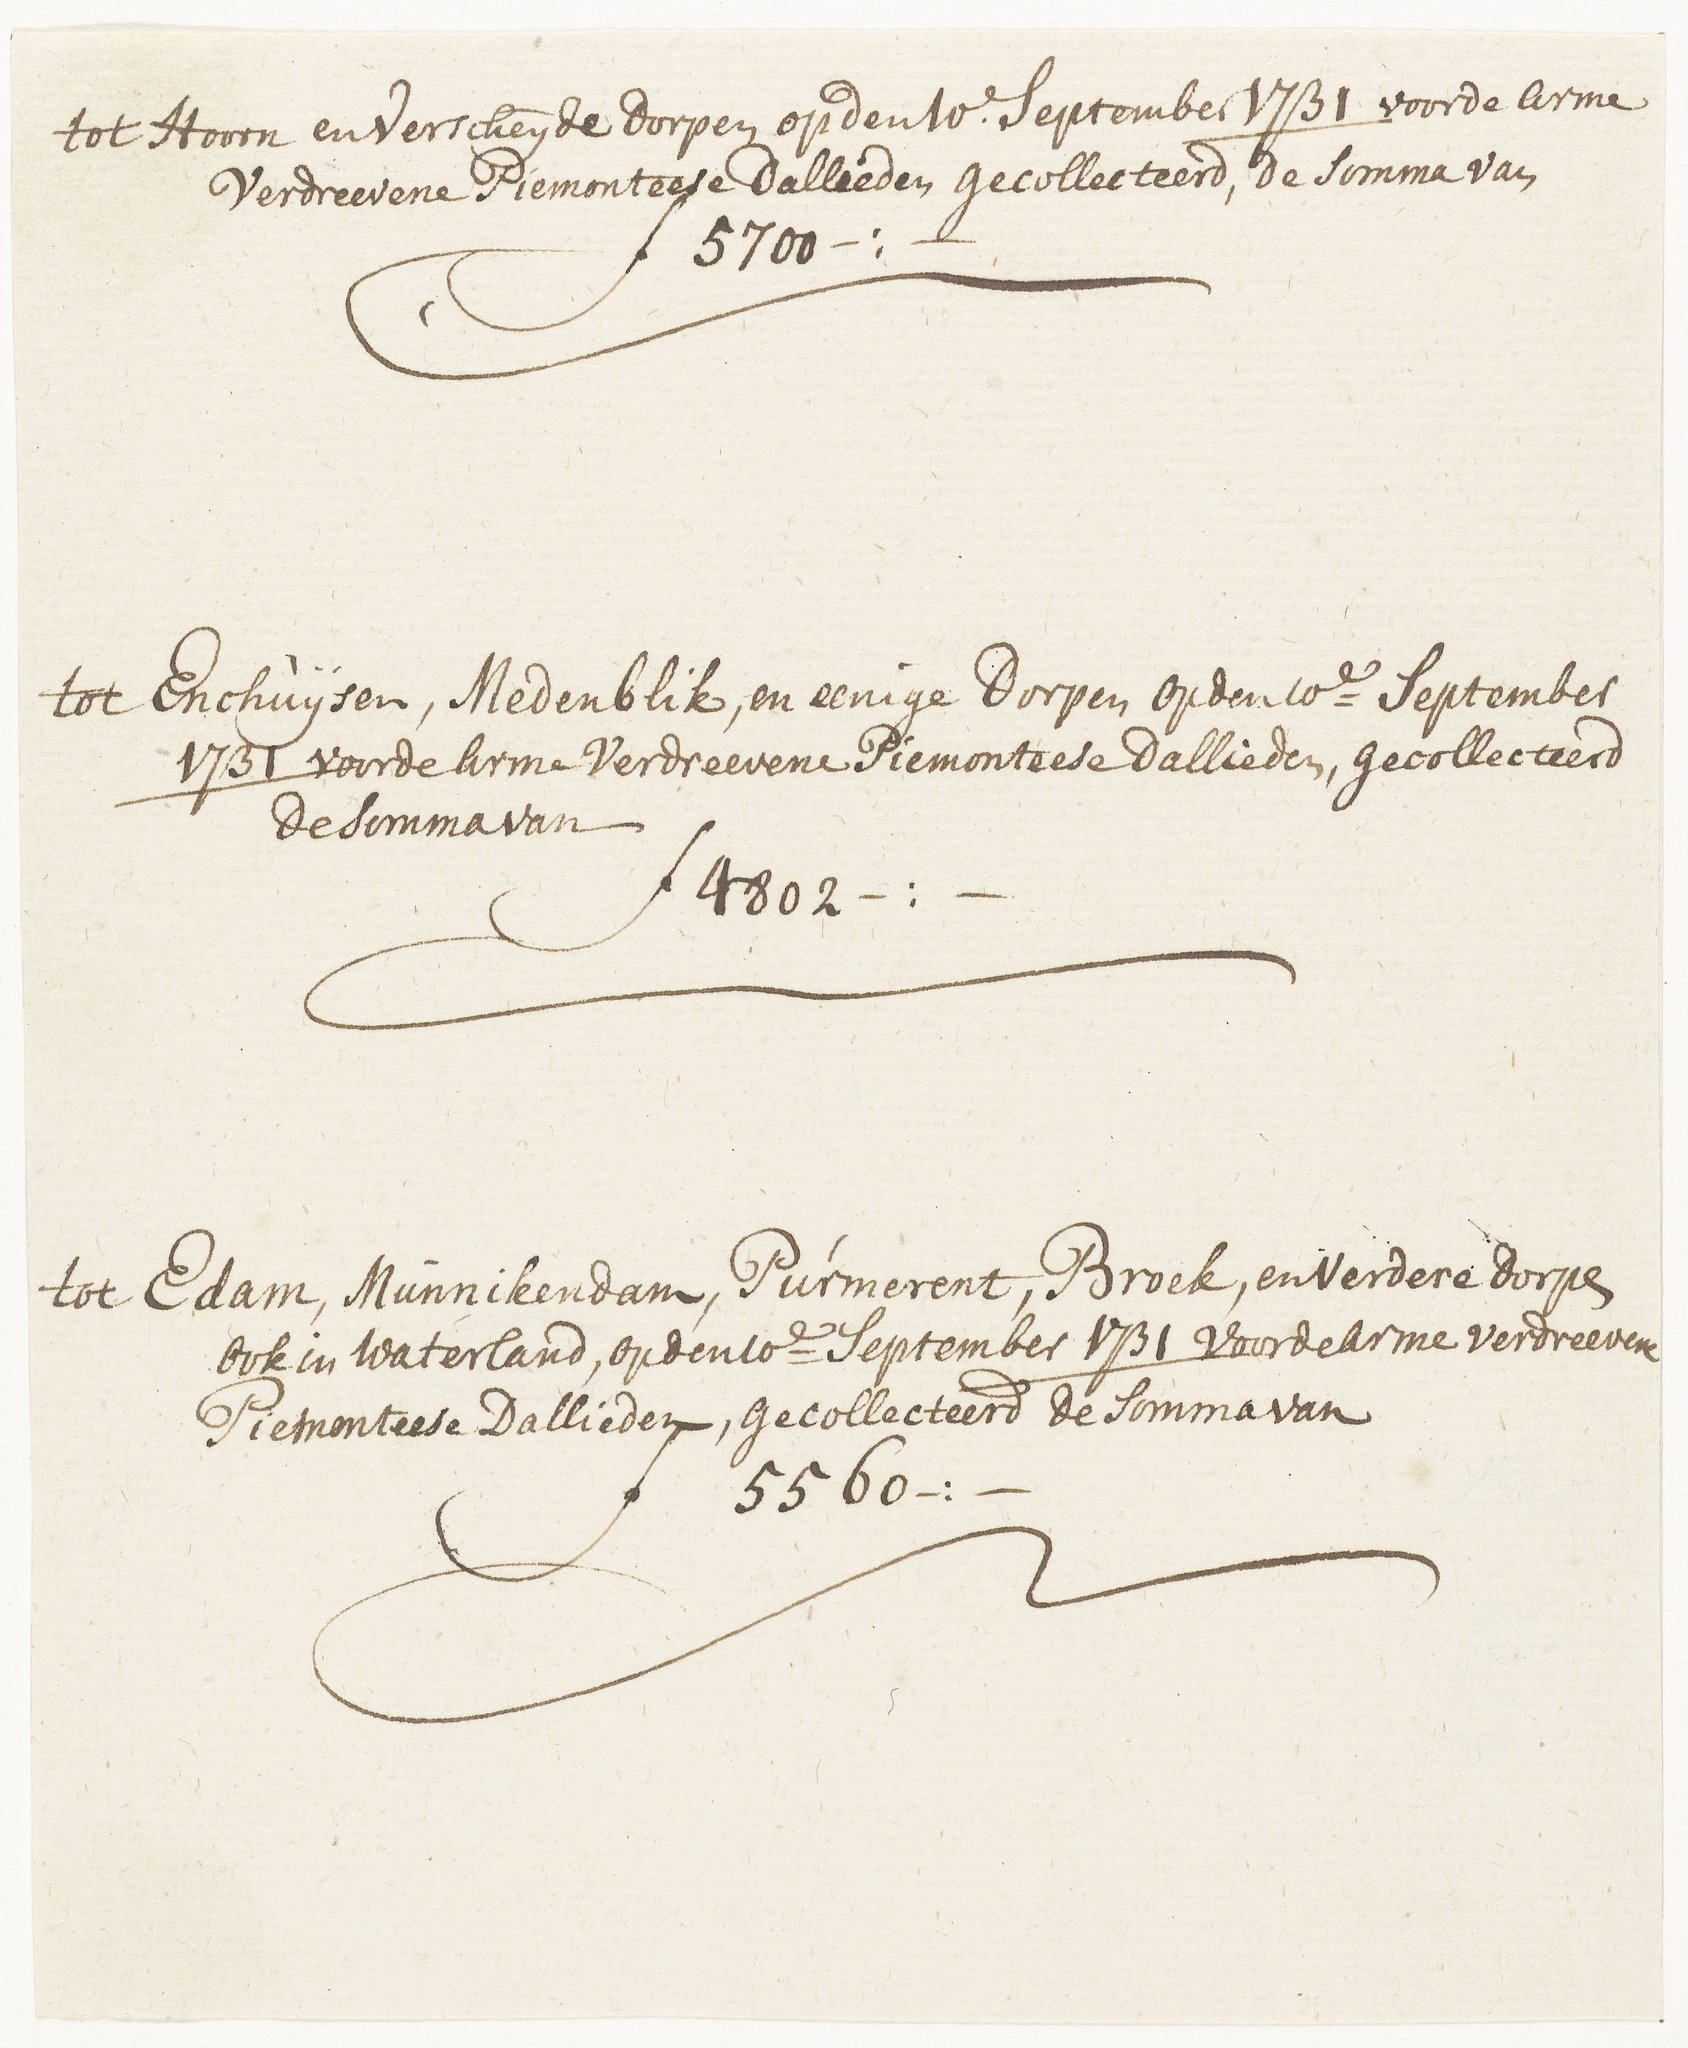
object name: manuscript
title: Opgave van de opbrengsten van de collectes voor de verdreven Piemontezen, 1731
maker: Anonymous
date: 1731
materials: paper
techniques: writing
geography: northern netherlands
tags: piemonte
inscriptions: collector's mark: Lugt 2228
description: Blaadje met de opgave van de opbrengsten van de collectes voor de uit Piemonte verdreven gereformeerde Dallieden (Waldenzers) gehouden te Hoorn, Enkhuizen, Medemblik, Edam, Monnikendam en andere plaatsen, 10 september 1731.